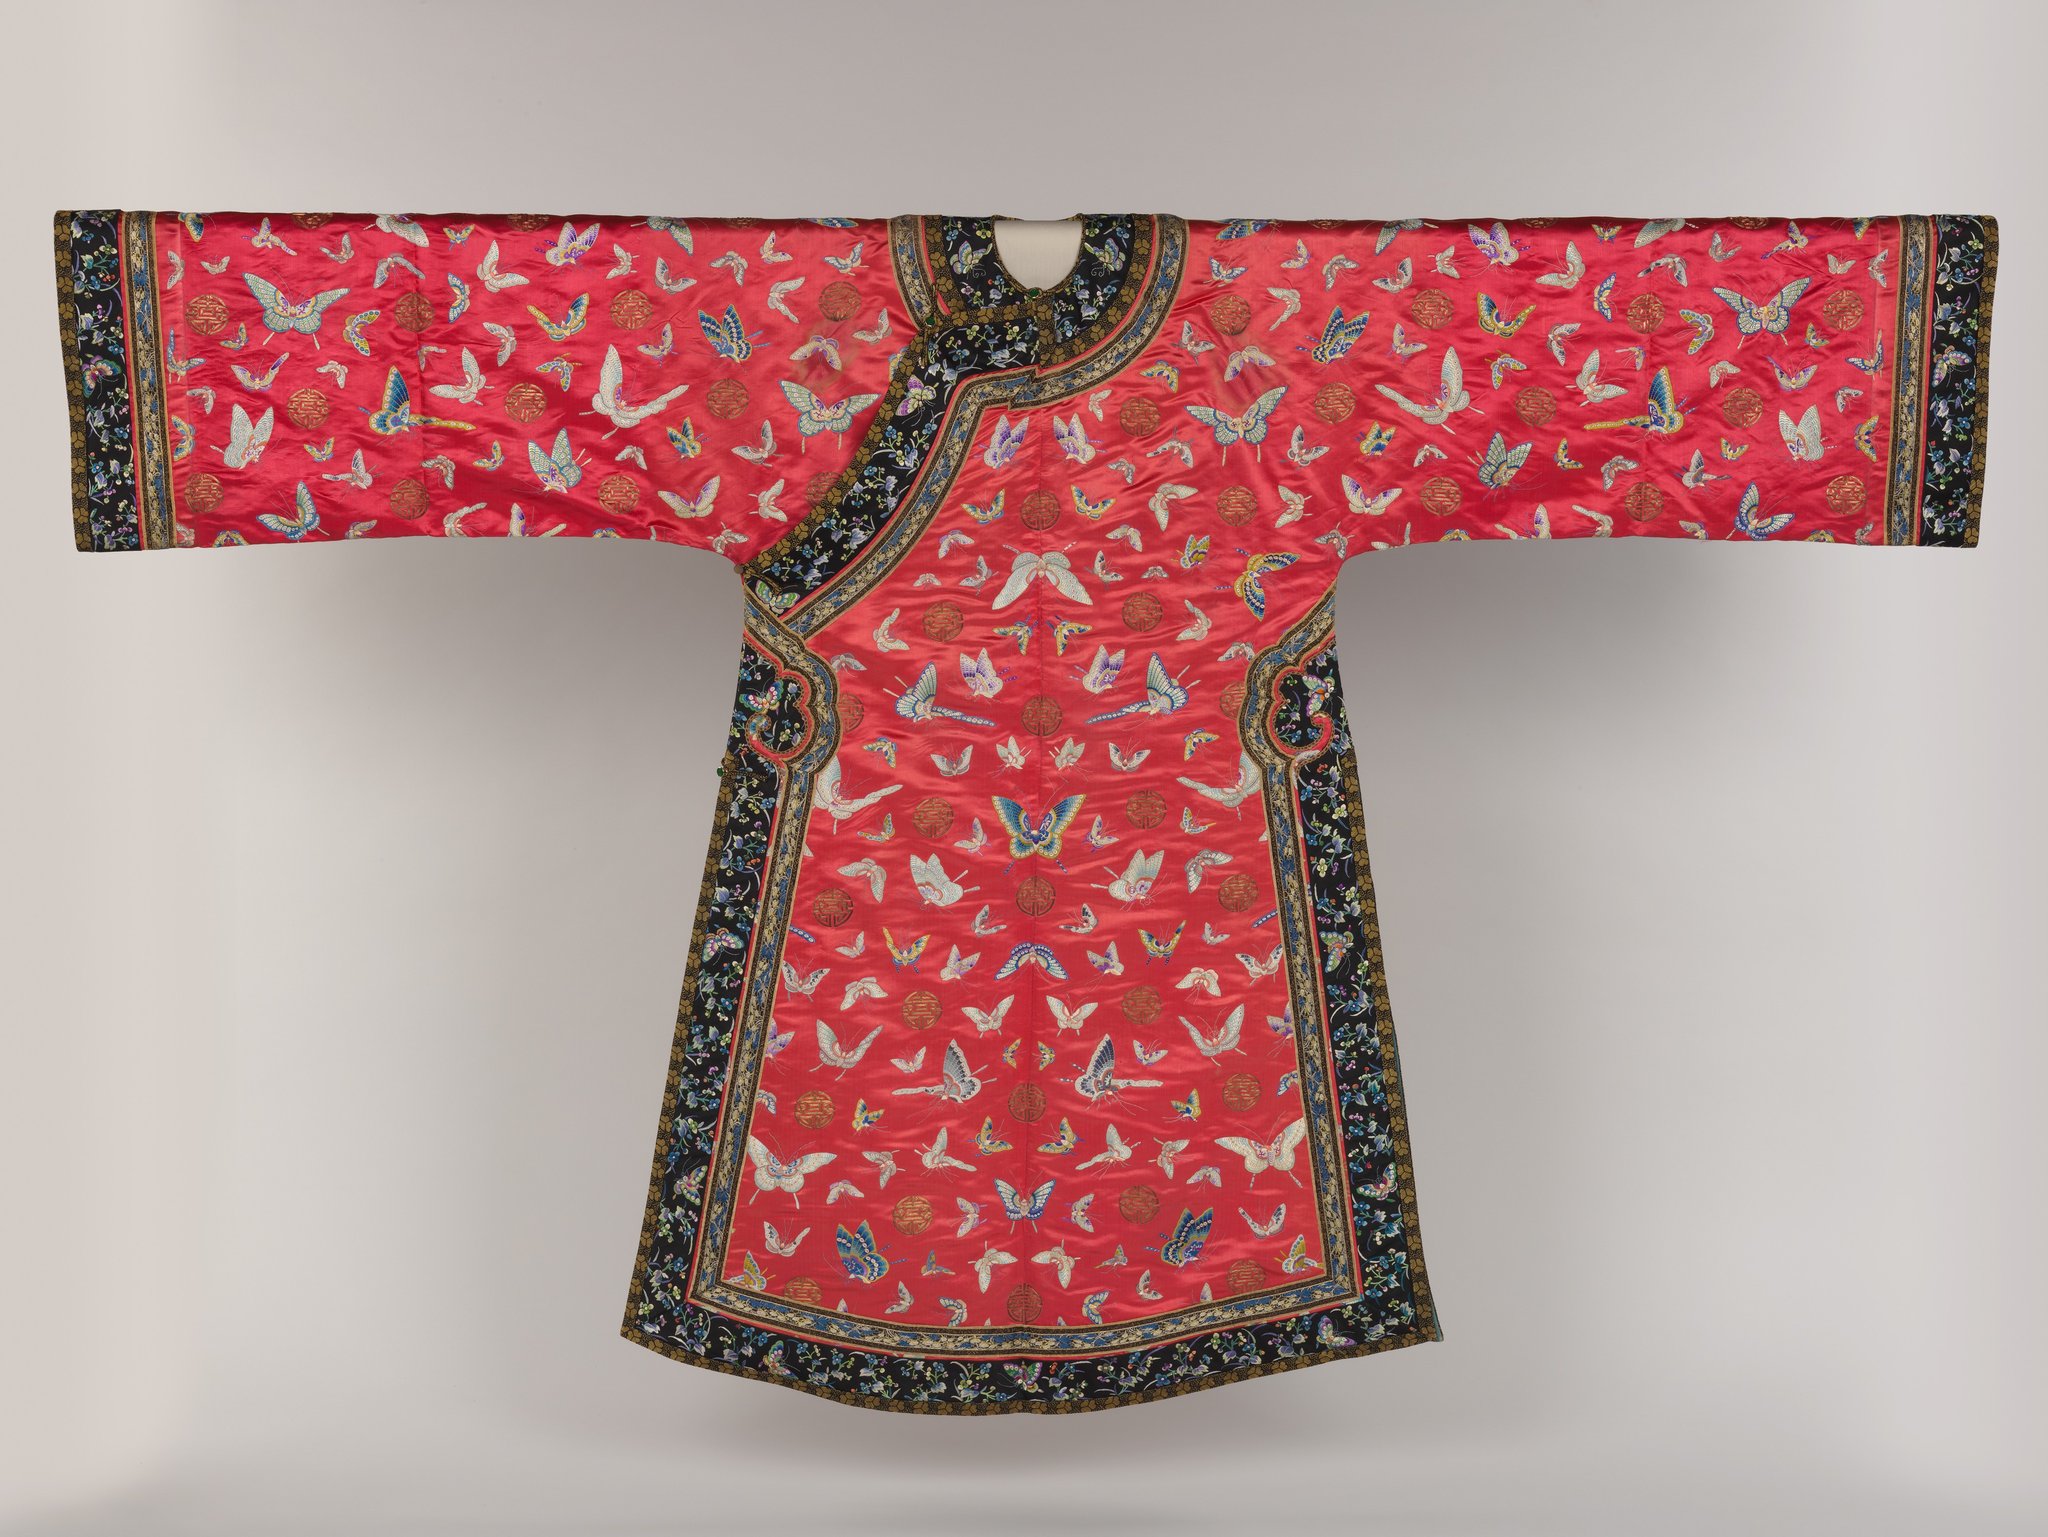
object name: robe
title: Woman’s robe with butterflies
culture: chinese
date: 1867-1900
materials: silk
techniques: embroidery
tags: butterflies